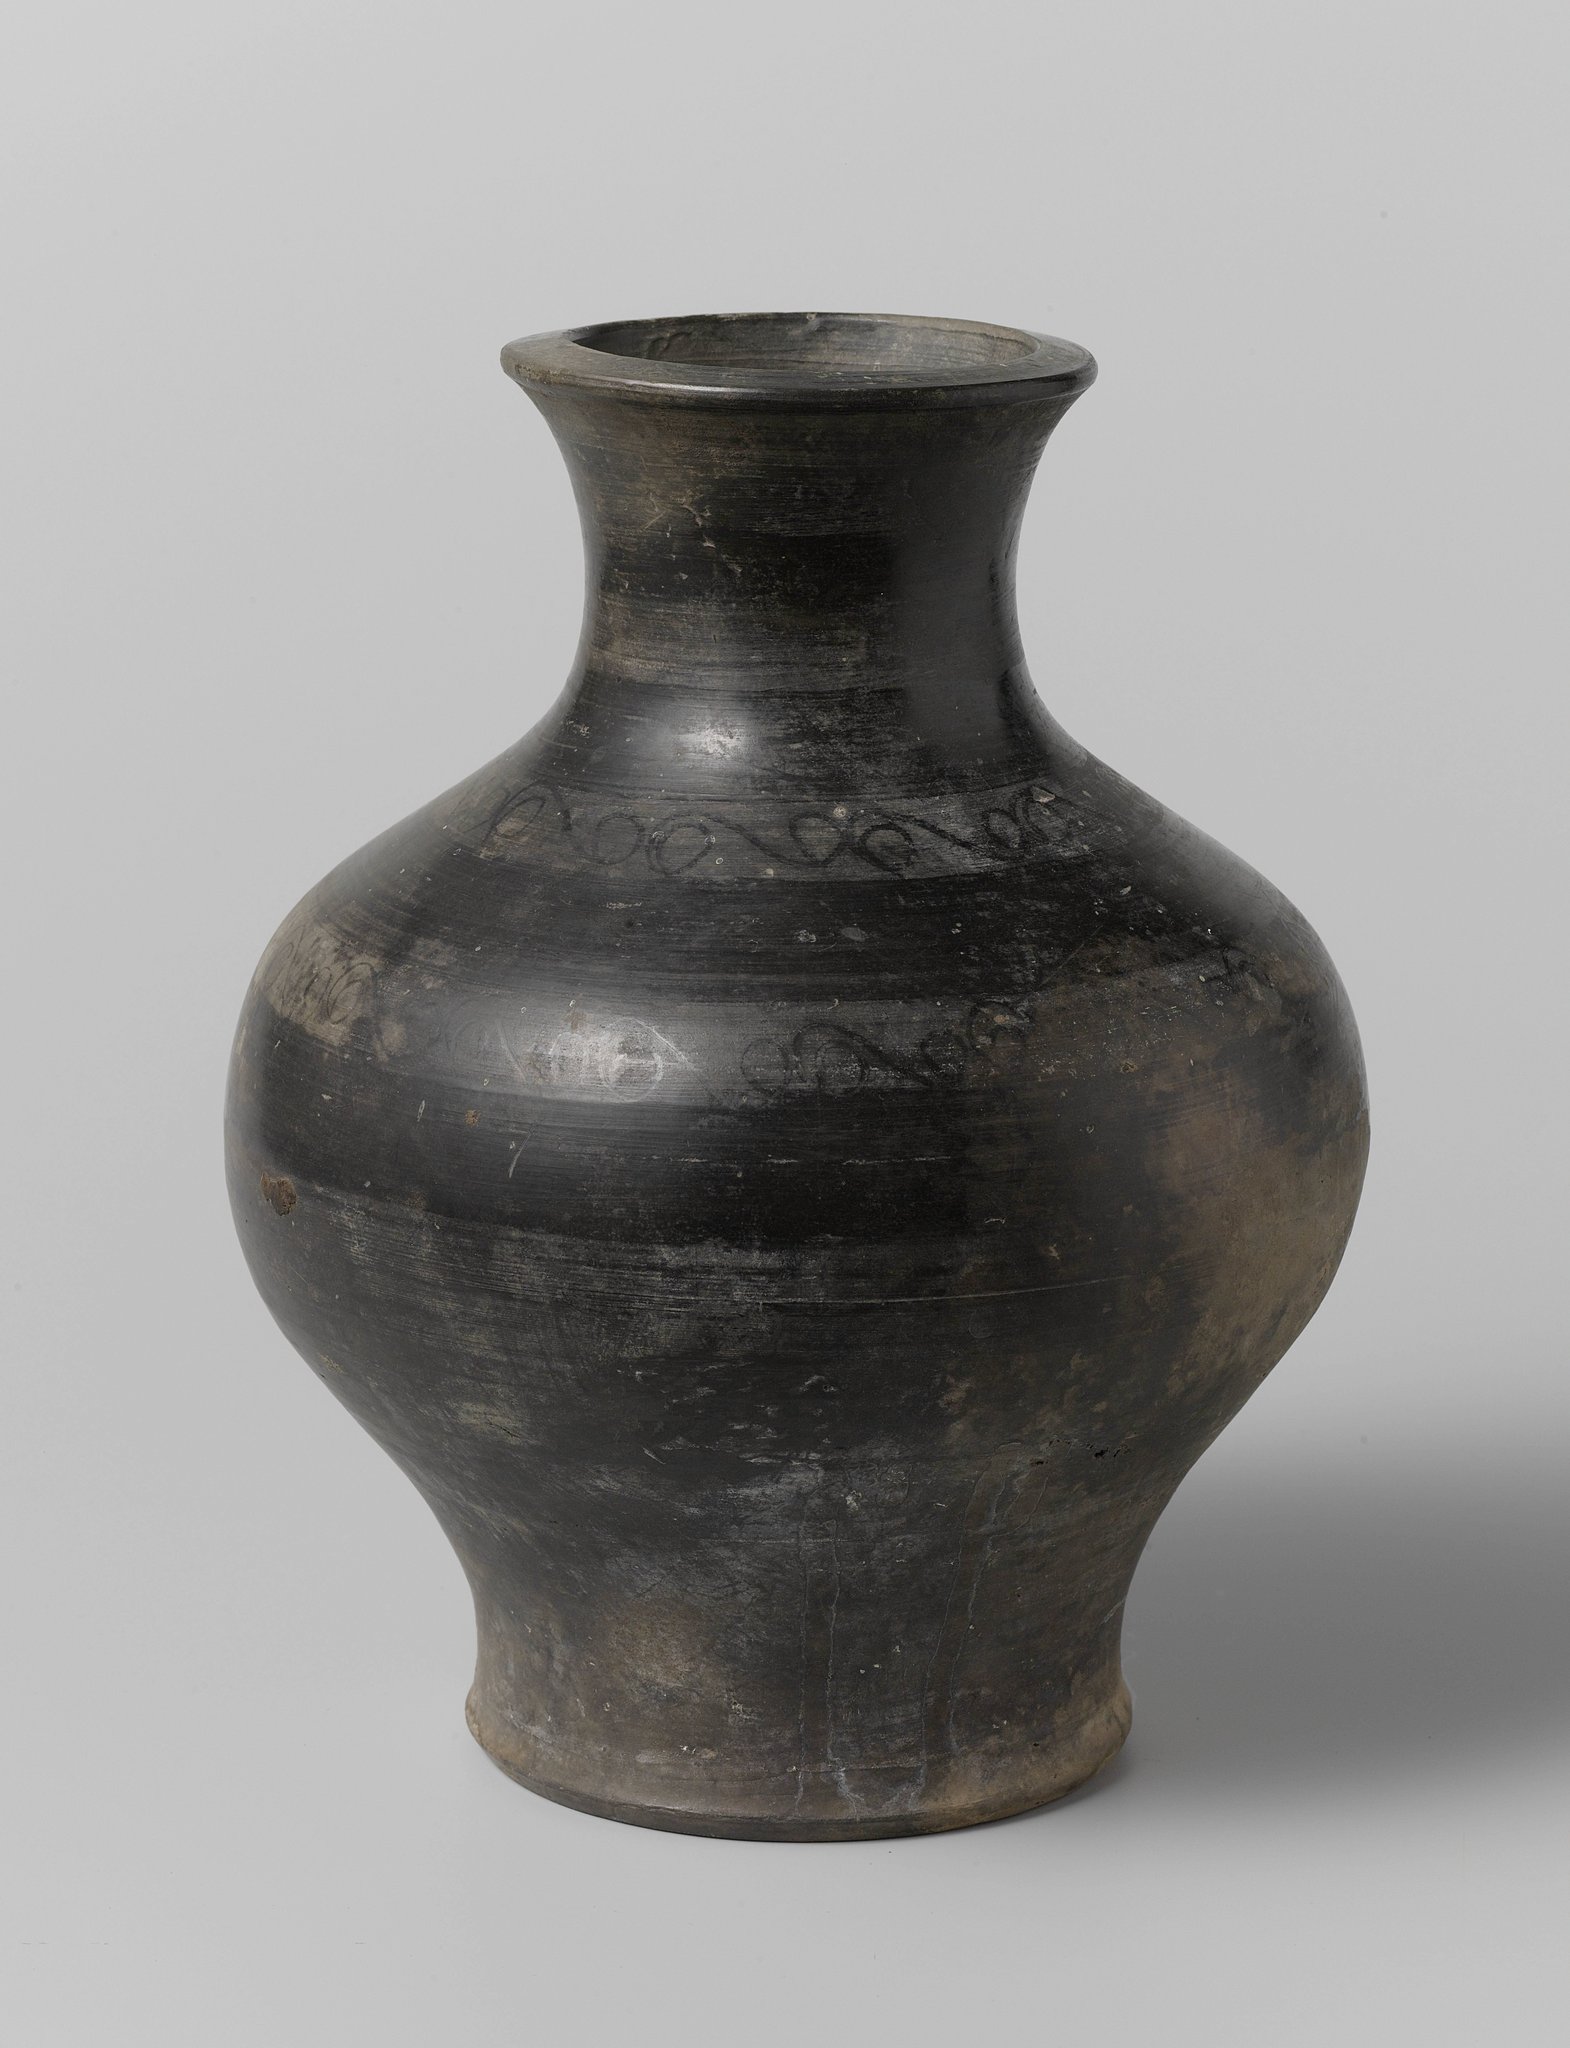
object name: vase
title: Jar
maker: Anonymous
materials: earthenware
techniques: firing, polish, turning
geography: china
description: This jar was used in a burial ritual. Although made of earthenware, the jar mimics the shape and colour of much more expensive materials, such as lacquers and bronze. The graceful volutes in the friezes presumably refer to clouds on which the deceased could ascend to heaven.